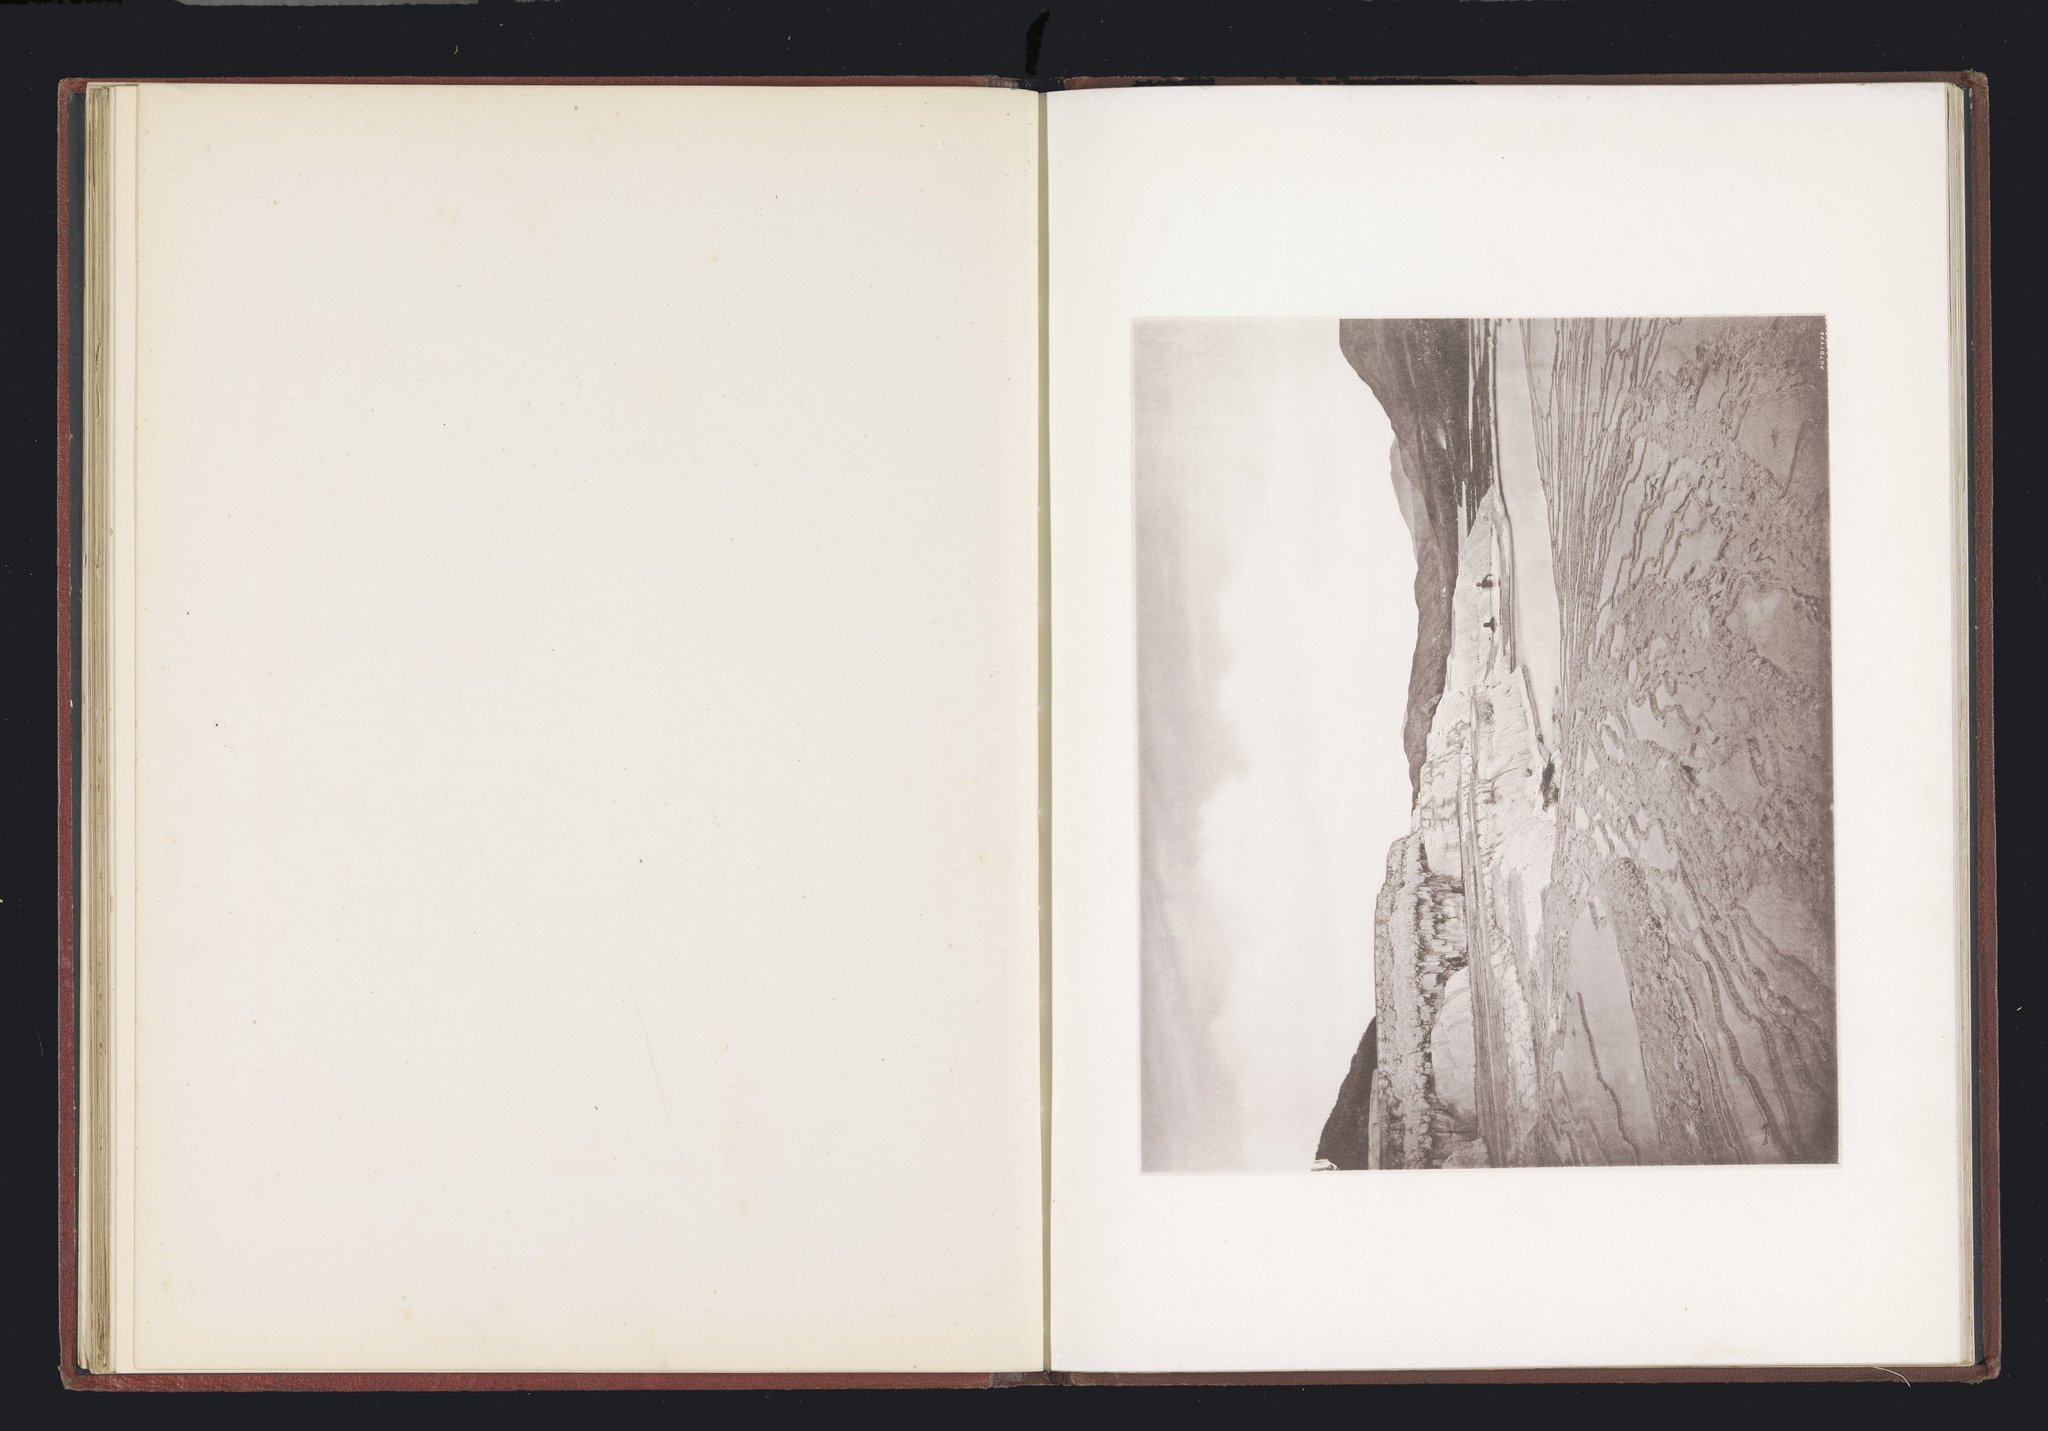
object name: page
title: Gezicht op de White Terraces te Lake Rotomahana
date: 1865-1875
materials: paper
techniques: photograph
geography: new zealand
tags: hot spring, geyser, lake